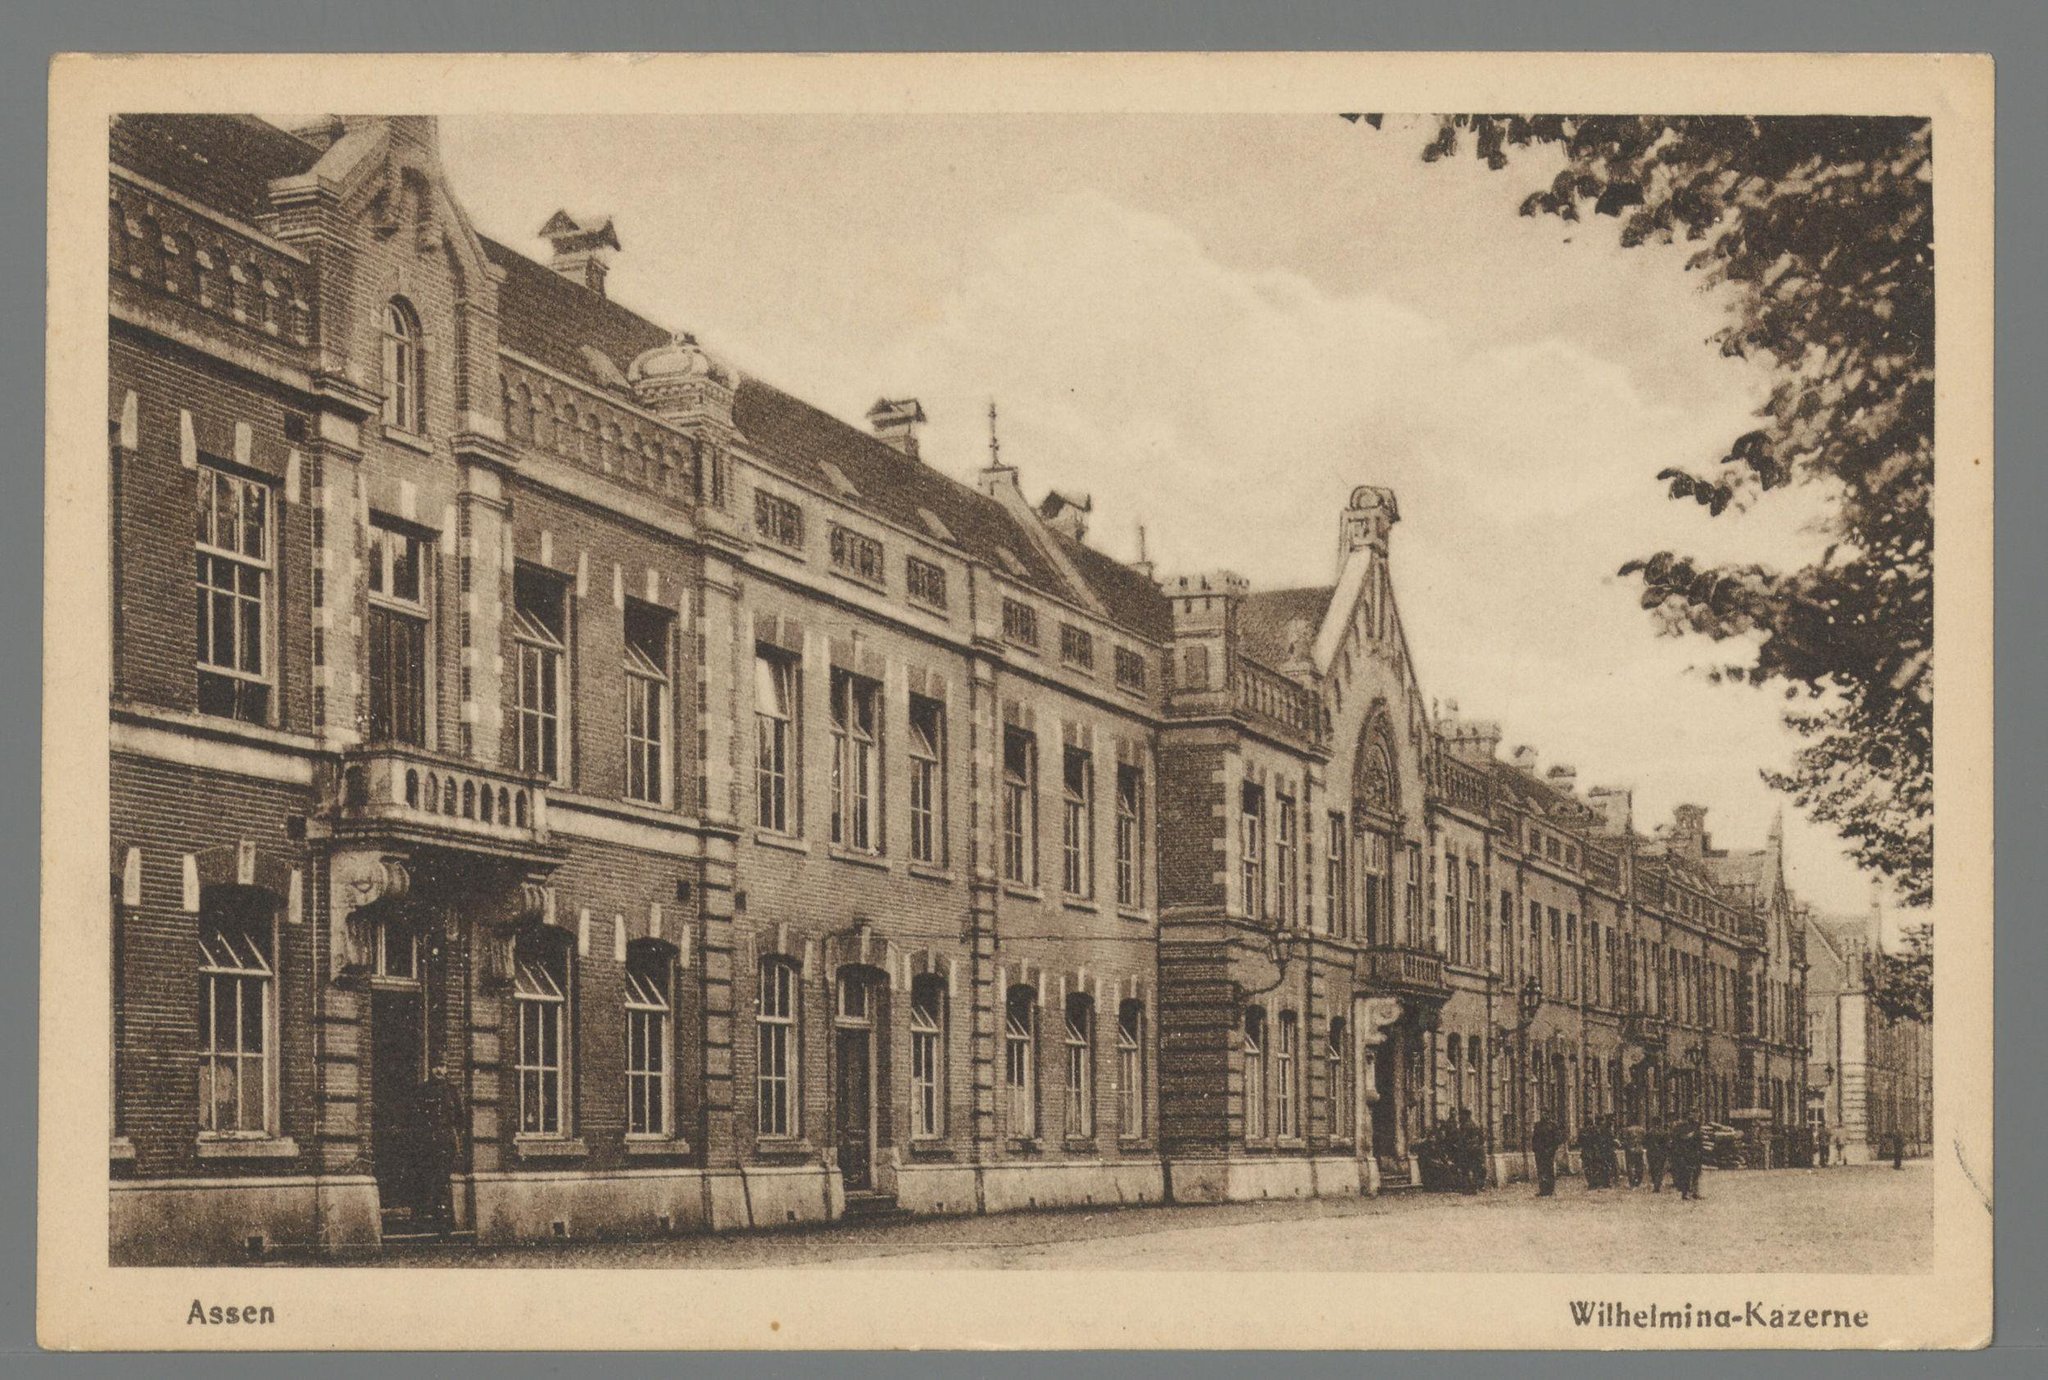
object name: photomechanical print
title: Assen. Wilhelmina-Kazerne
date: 1917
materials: cardboard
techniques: photograph, writing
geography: amsterdam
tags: barracks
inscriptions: postage stamp